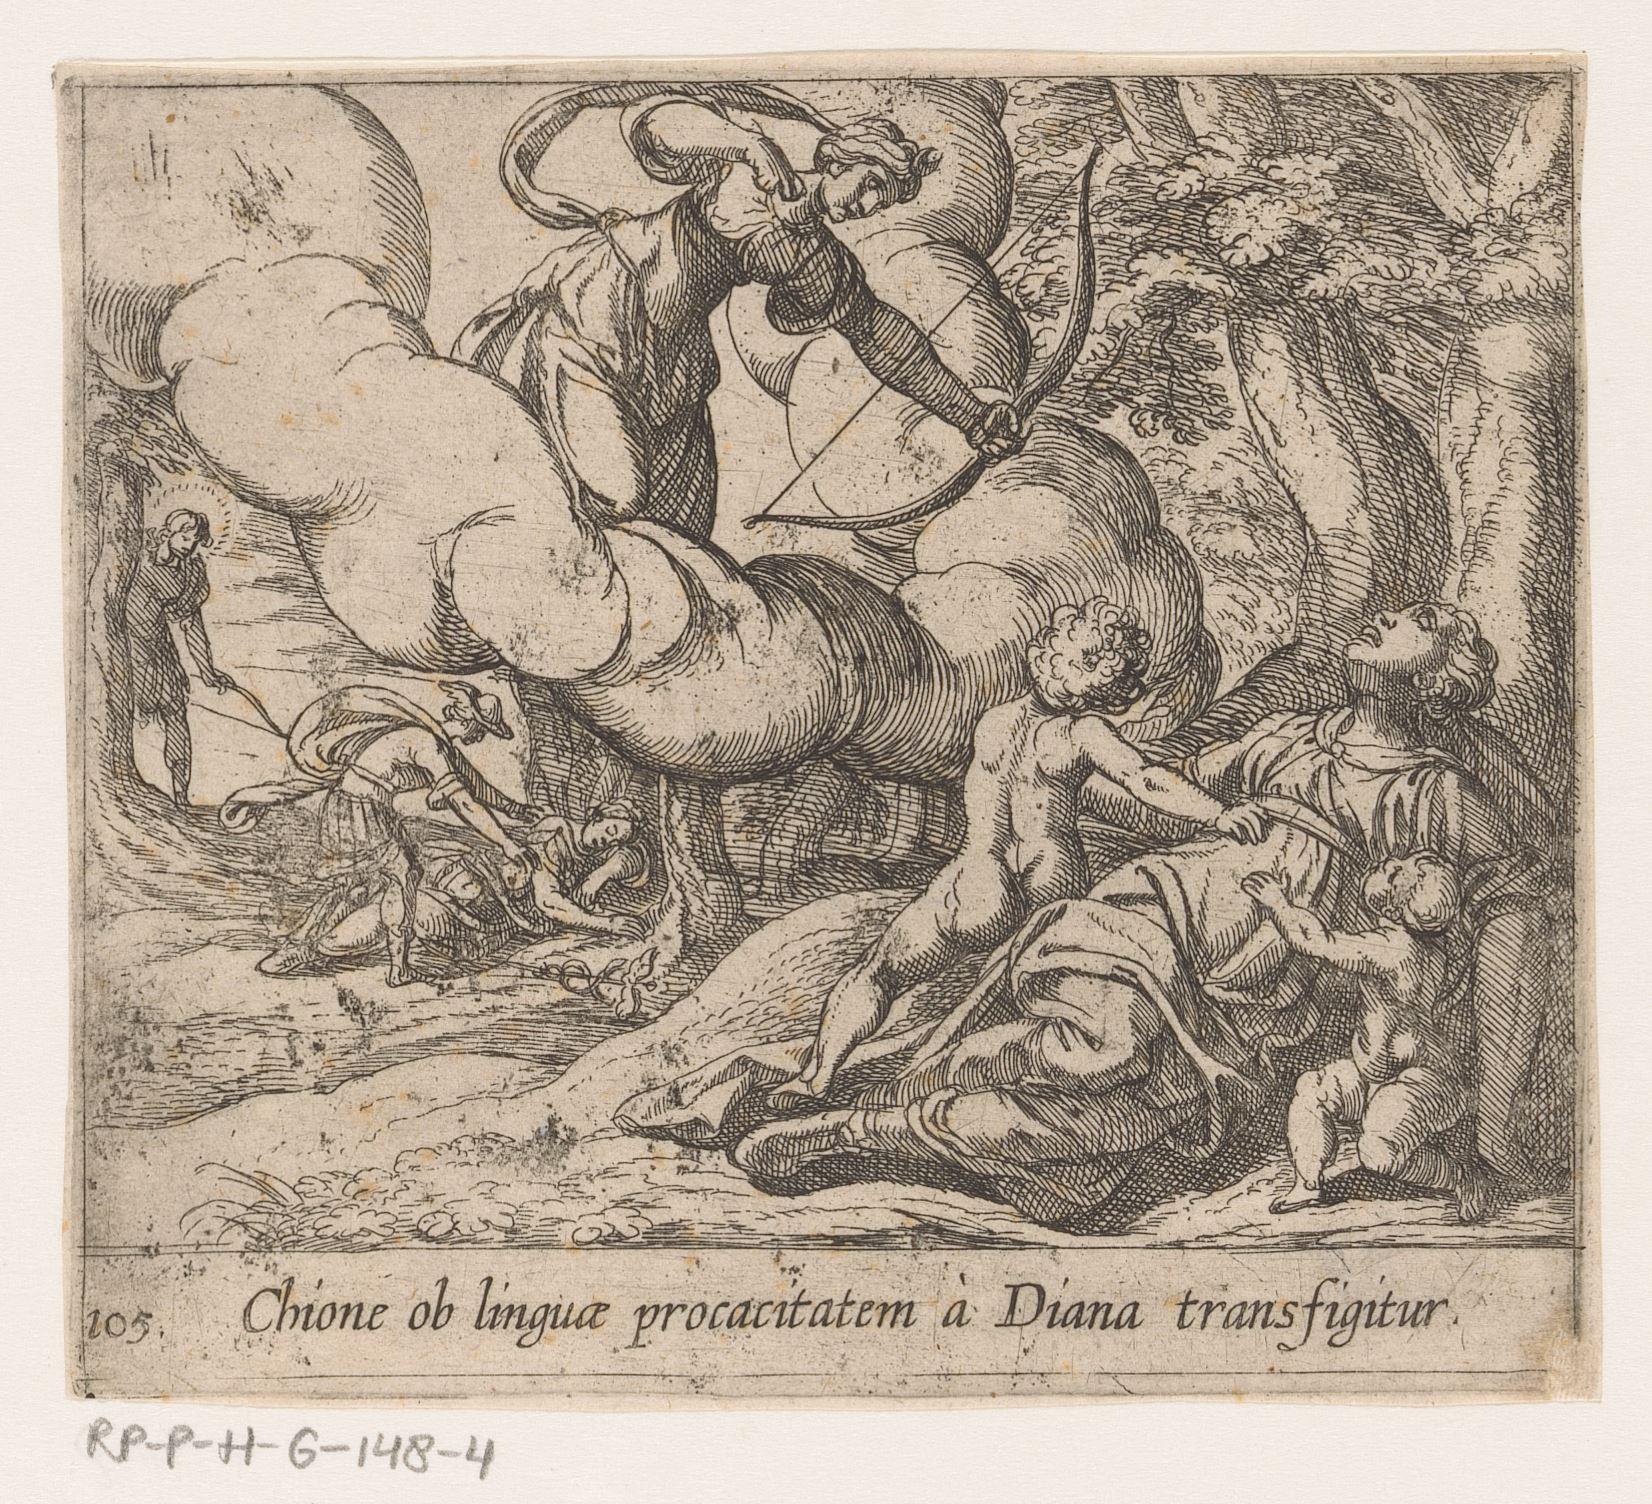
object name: print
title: Metamorfosen van Ovidius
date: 1606-1638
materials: paper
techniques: etching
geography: italy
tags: death of chione, daughter of daedalion: she is shot in the tongue by diana for comparing her own beauty with that of the goddess, mercury wooing chione; apollo present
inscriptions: collector's mark: ‘Hinloopen’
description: Diana schiet Chione dood met pijl-en-boog, omdat Chiona haar eigen schoonheid vergeleek met die van de godin. Op de achtergrond wordt Chione verleid door Mercurius, terwijl Apollo toekijkt vanachter een boom. Titel in het Latijn in ondermarge.